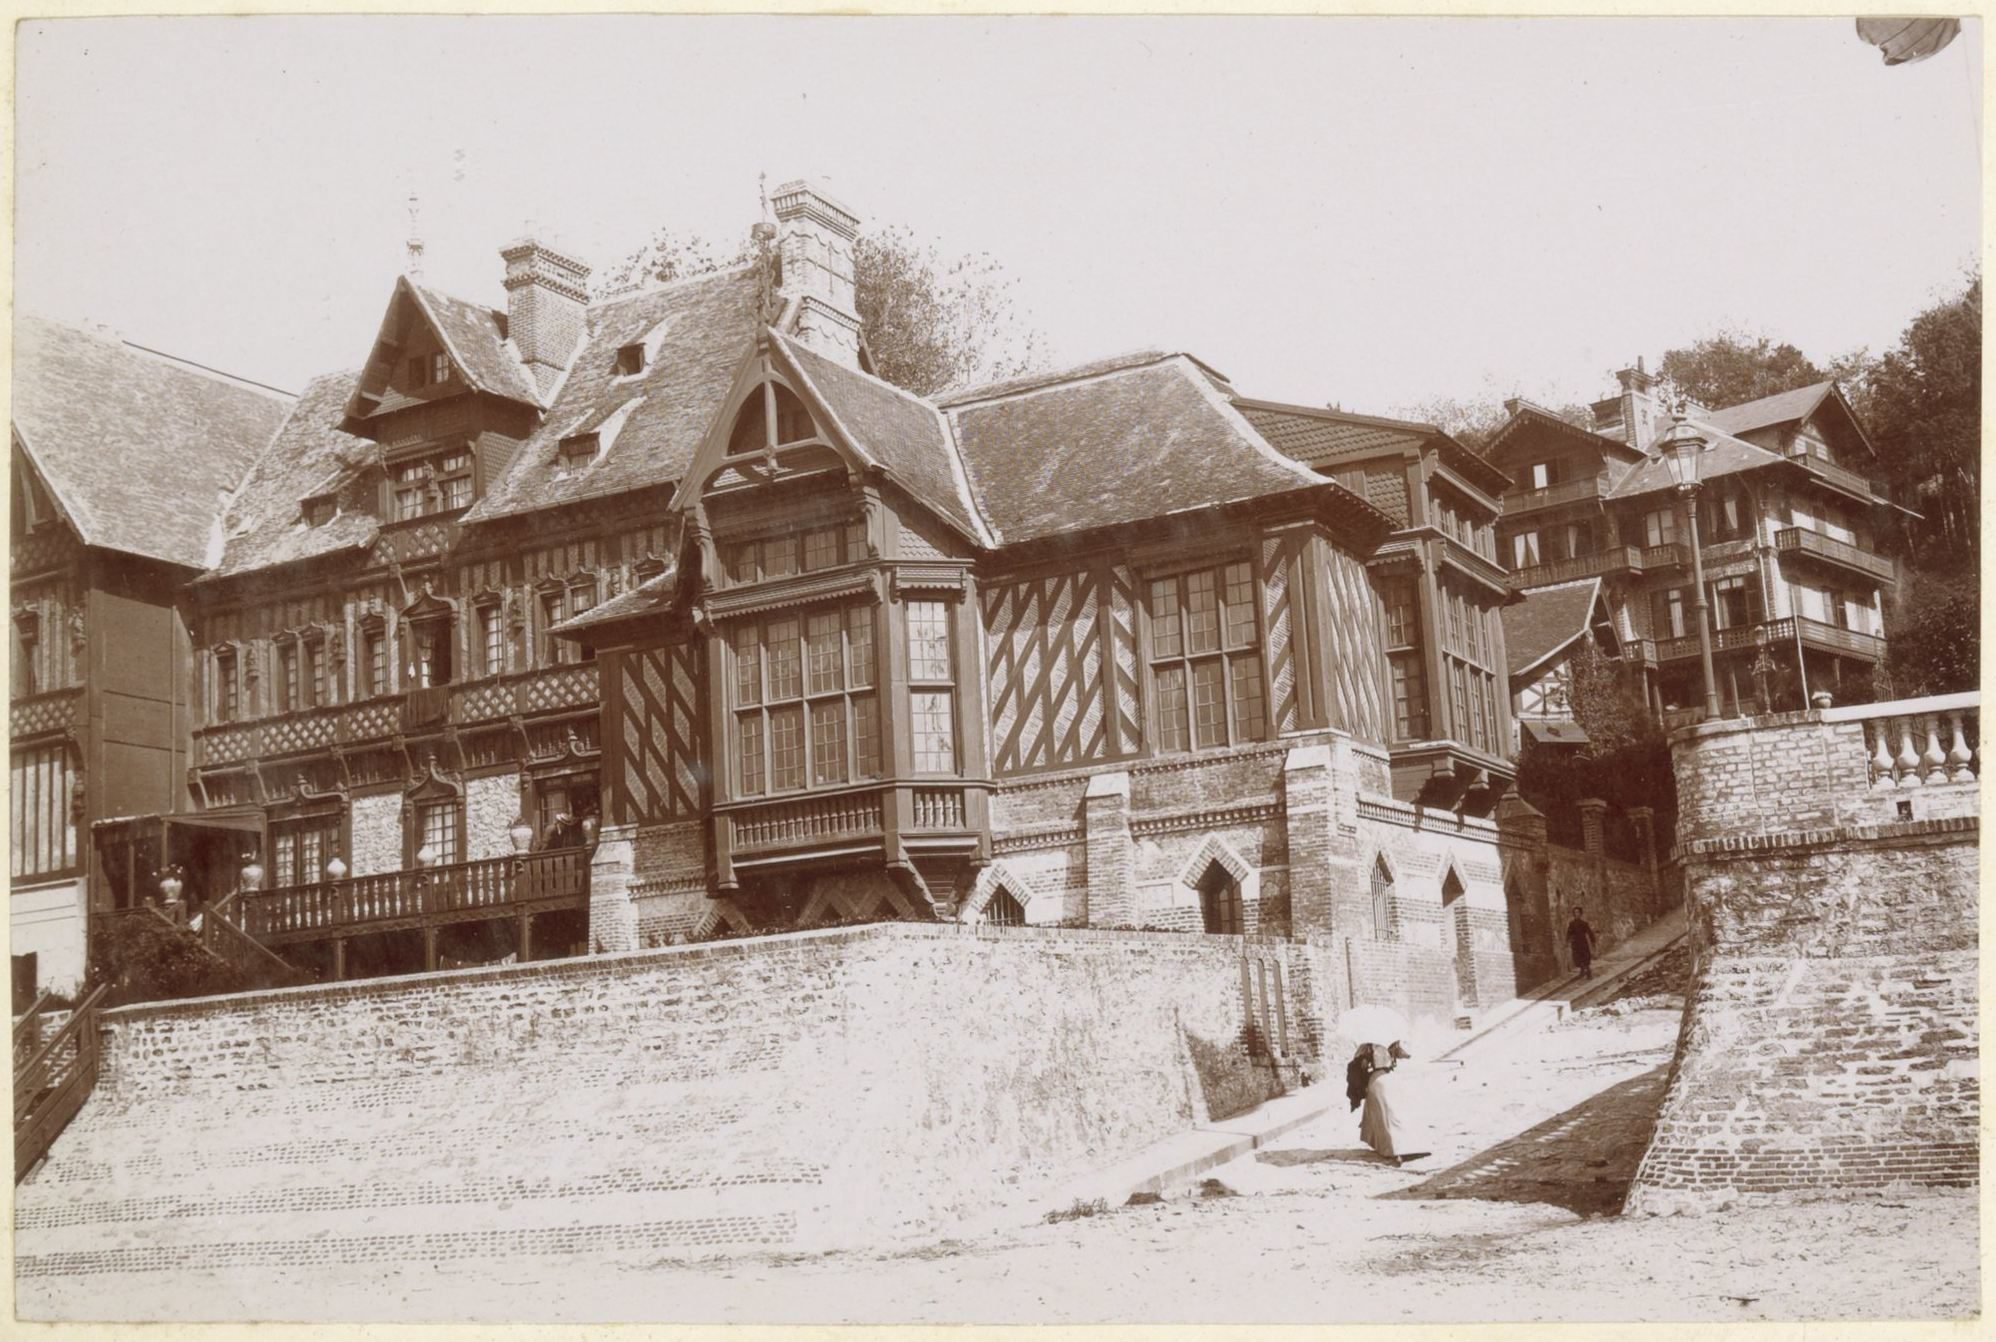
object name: photograph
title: Exterieur van een landhuis aan de Franse kust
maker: Anonymous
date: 1900-1910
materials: paper, photographic support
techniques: daylight paper print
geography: france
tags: rural housing, e.g. country-house, villa, cottage, façade (of house or building), france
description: Onderdeel van Fotoalbum van een Franse amateurfotograaf met opnames van een familie, distilleerderij Delizy & Doistau Fils, het leger en bezienswaardigheden in Frankrijk.